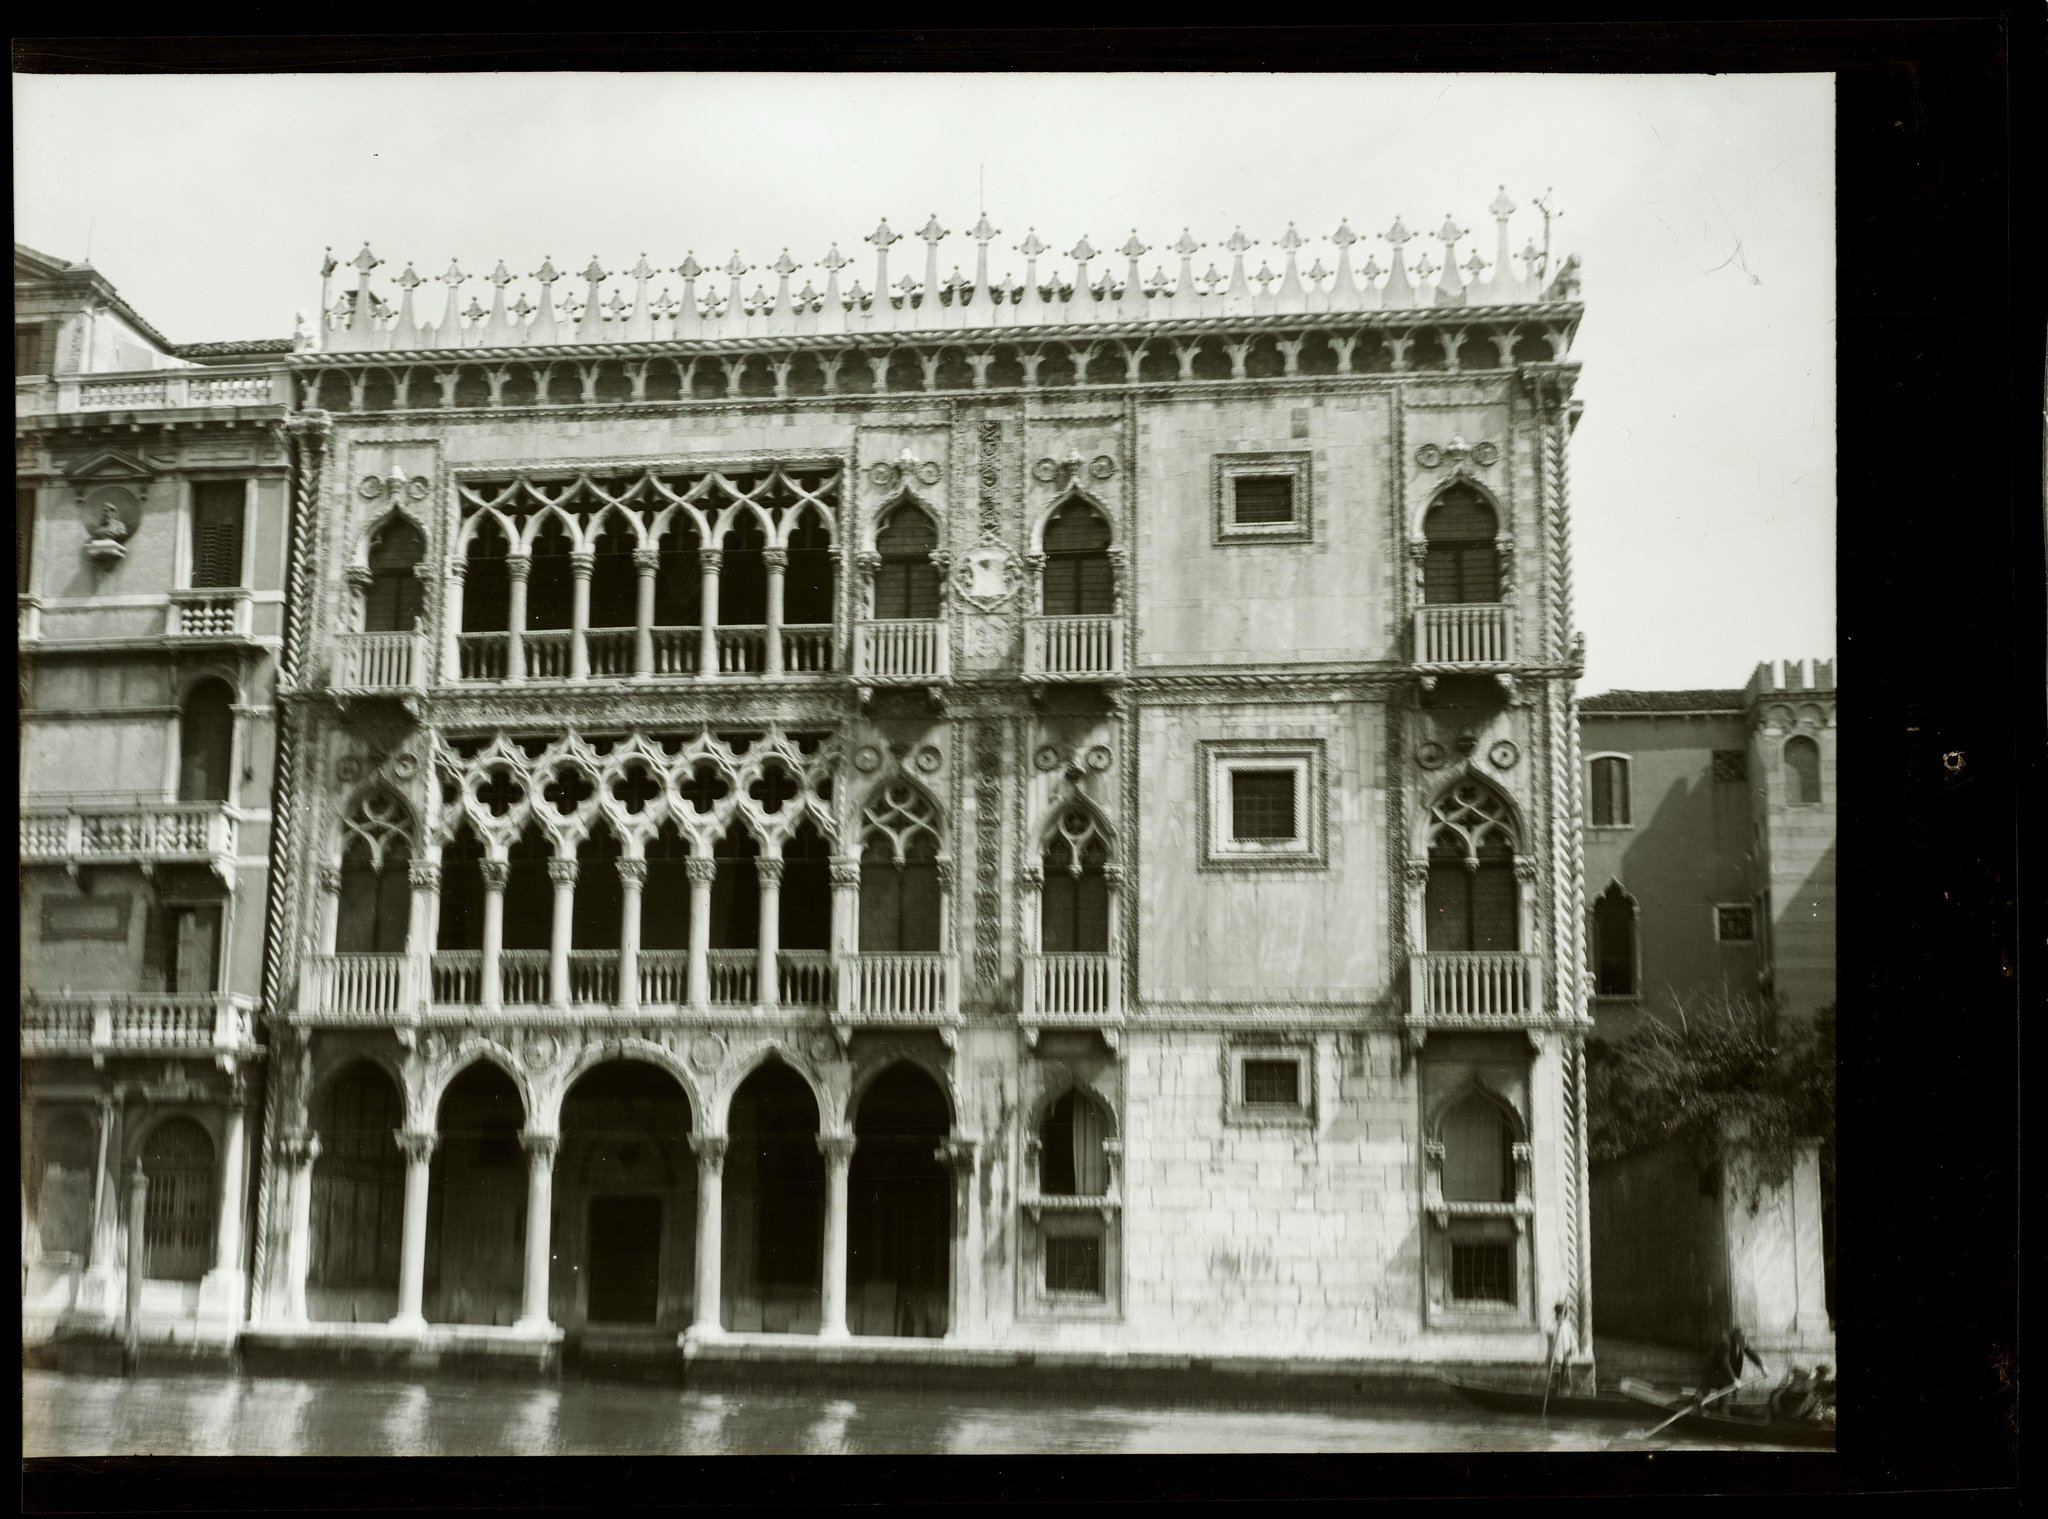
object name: photograph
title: Filmnegatief met opname van Venetië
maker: Anonymous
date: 1907-1935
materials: film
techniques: gelatin silver negative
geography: venice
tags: venice